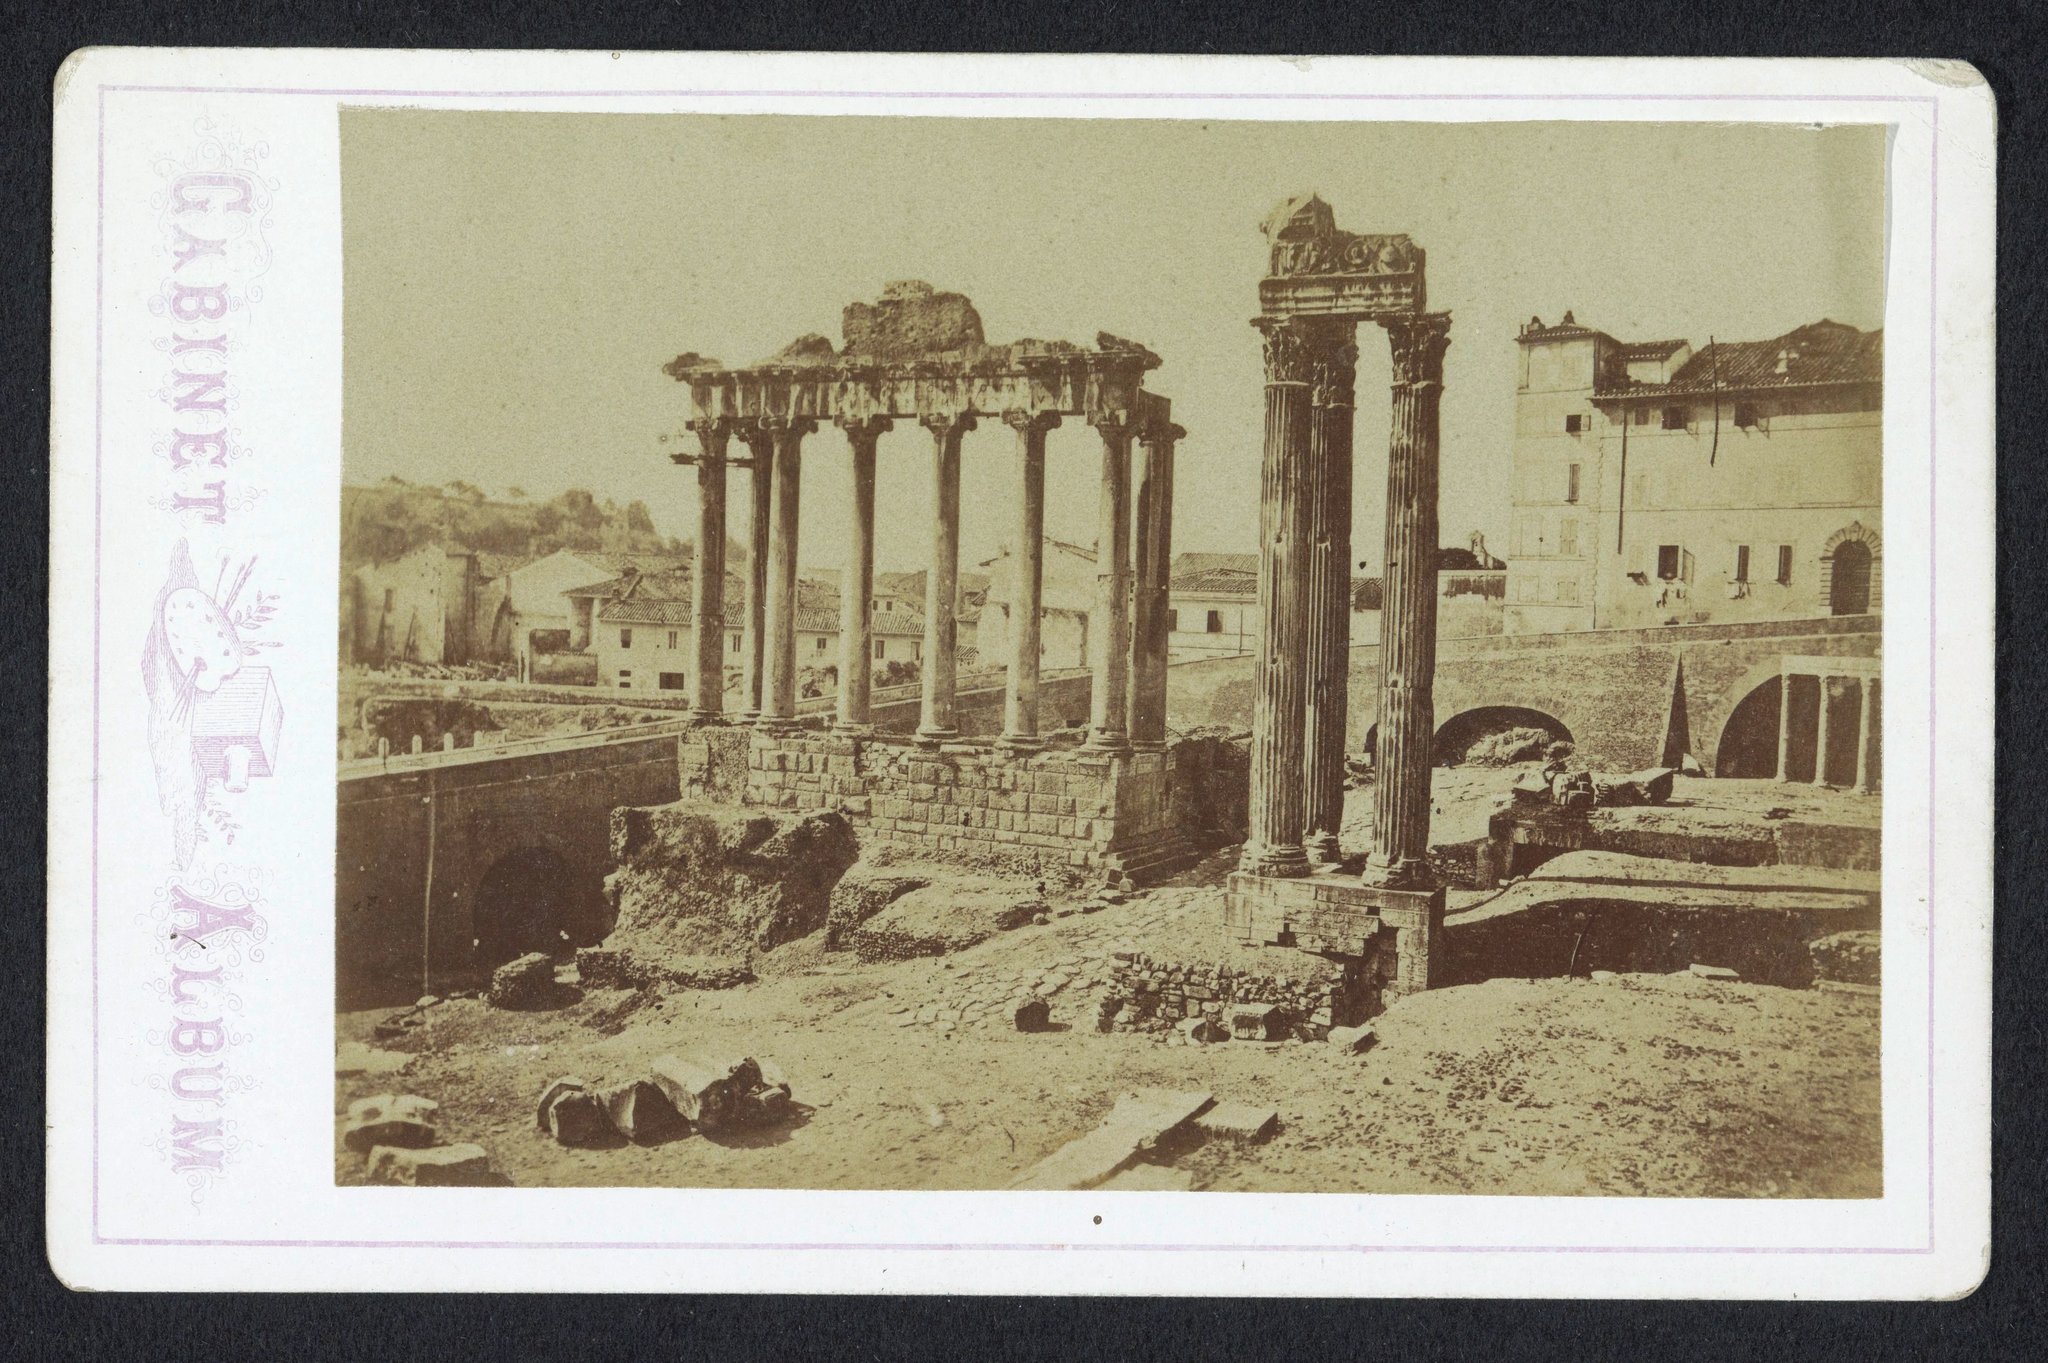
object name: cabinet photograph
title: Gezicht op het Forum Romanum in Rome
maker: Anonymous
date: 1850-1900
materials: cardboard, photographic support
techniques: albumen print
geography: tempel van caesar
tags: ruin of a building ~ architecture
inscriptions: annotation: ‘foro Romana/ Roma’, inscription: ‘Cabinet Album’